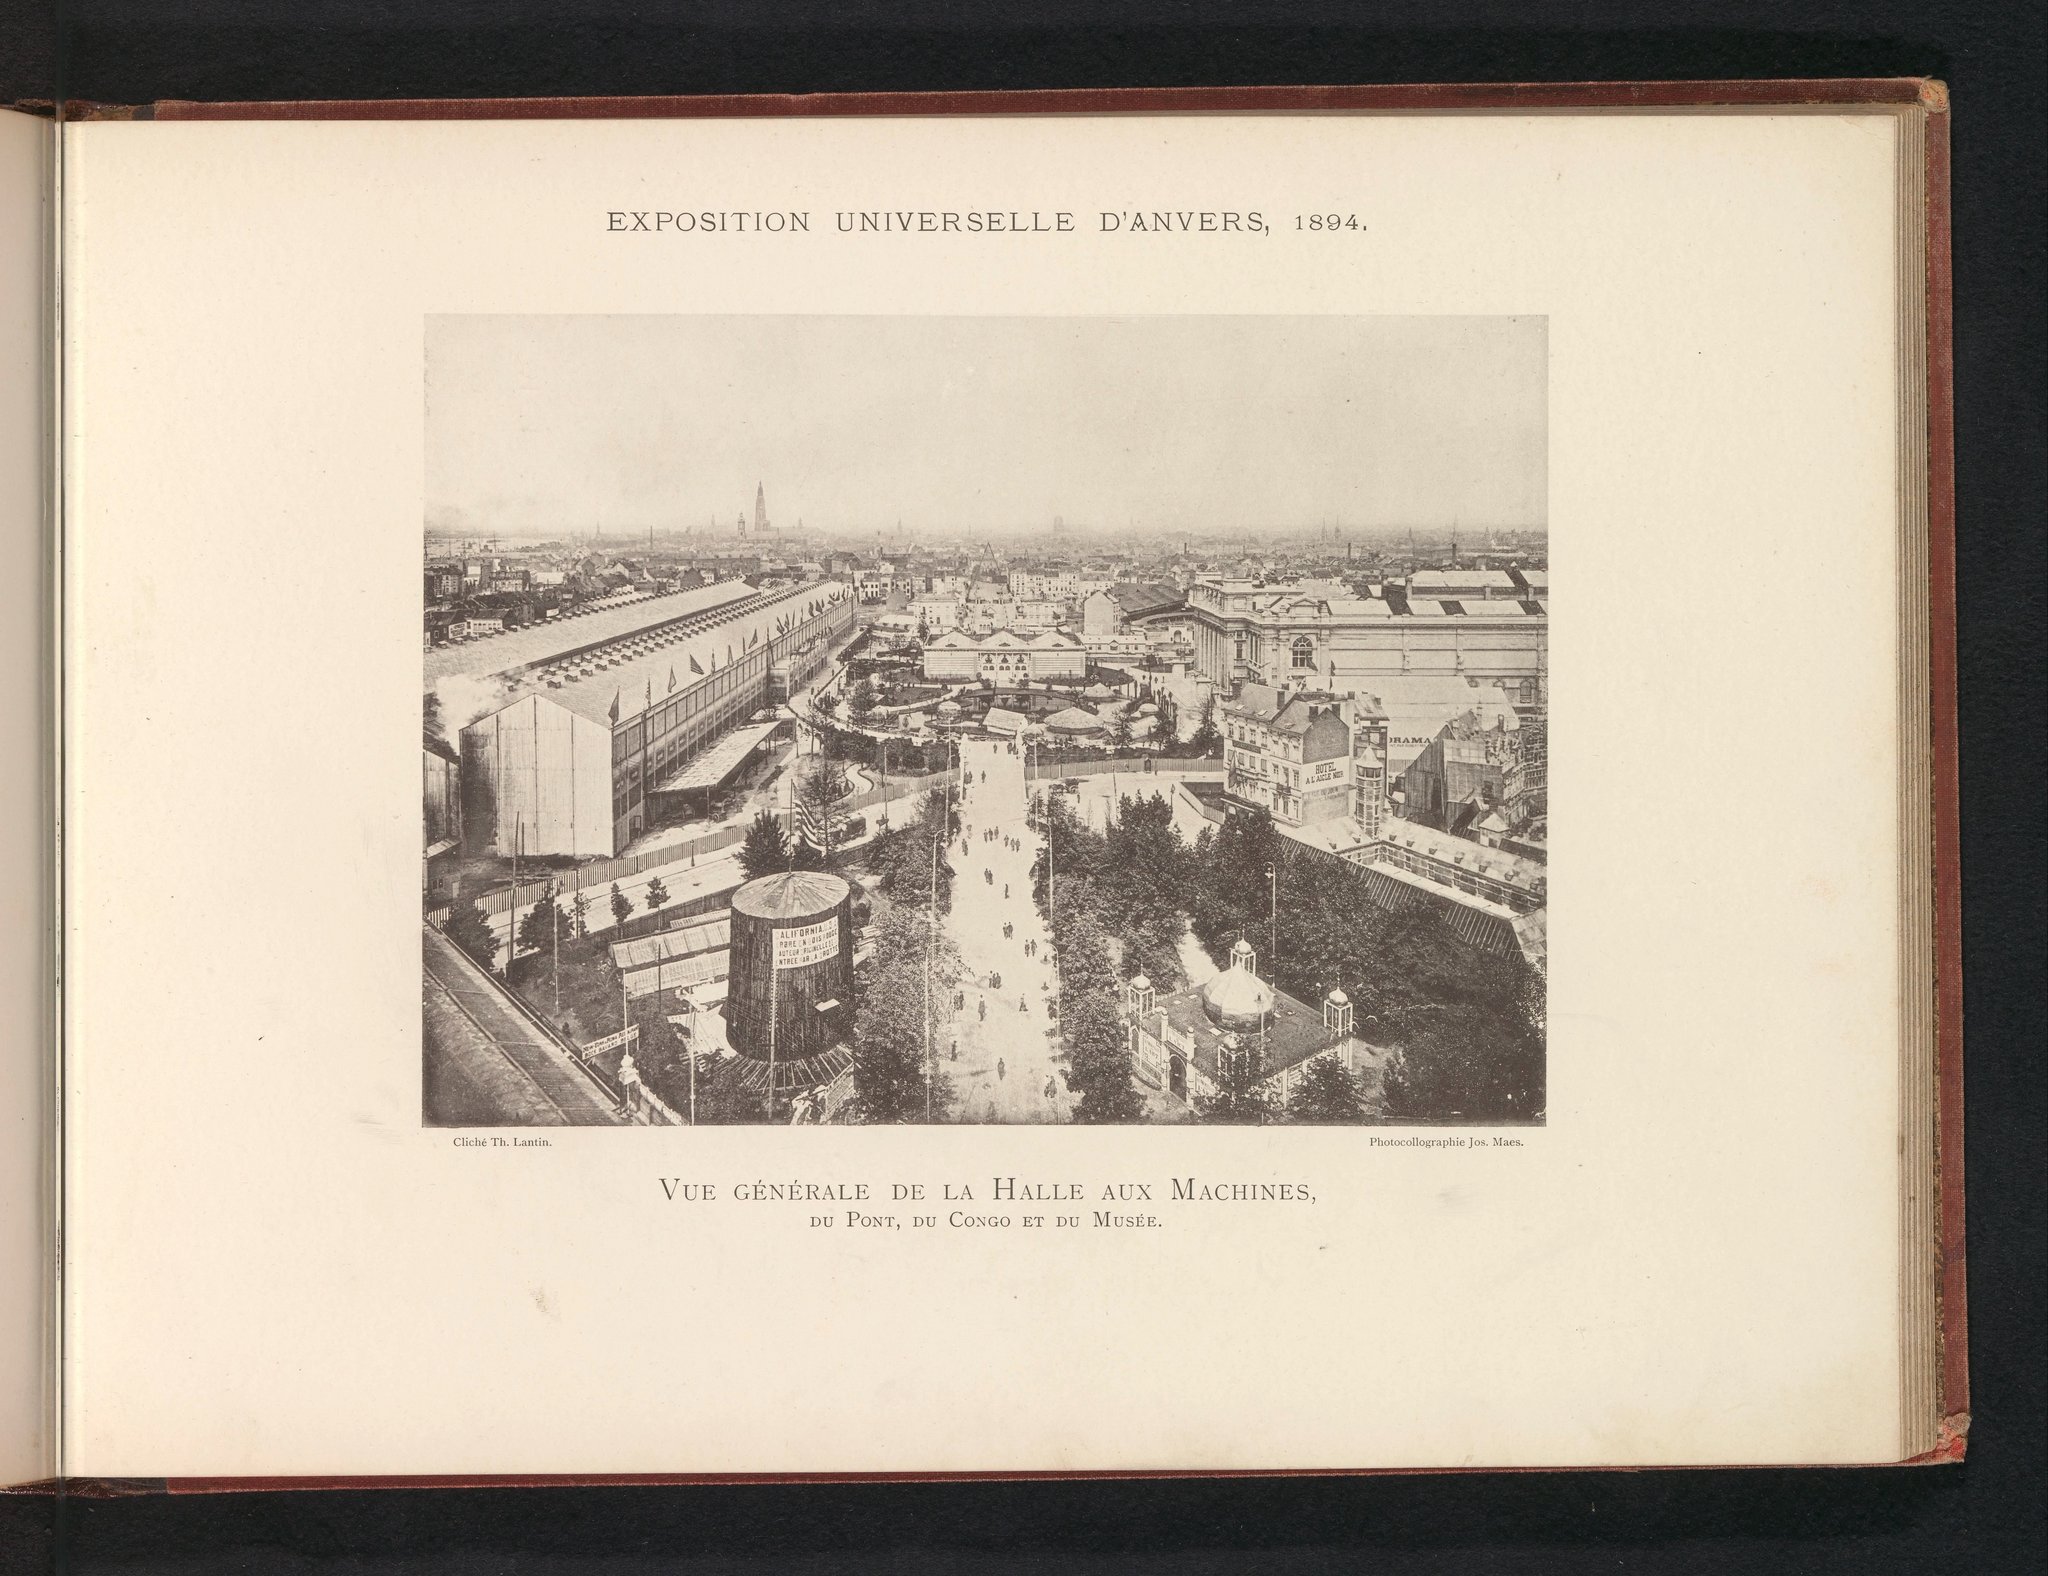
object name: page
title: Vue générale de la halle aux machines, du pont, du Congo et du musée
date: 1894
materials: paper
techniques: photograph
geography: antwerp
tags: world fair, world exhibition, façade (of house or building)